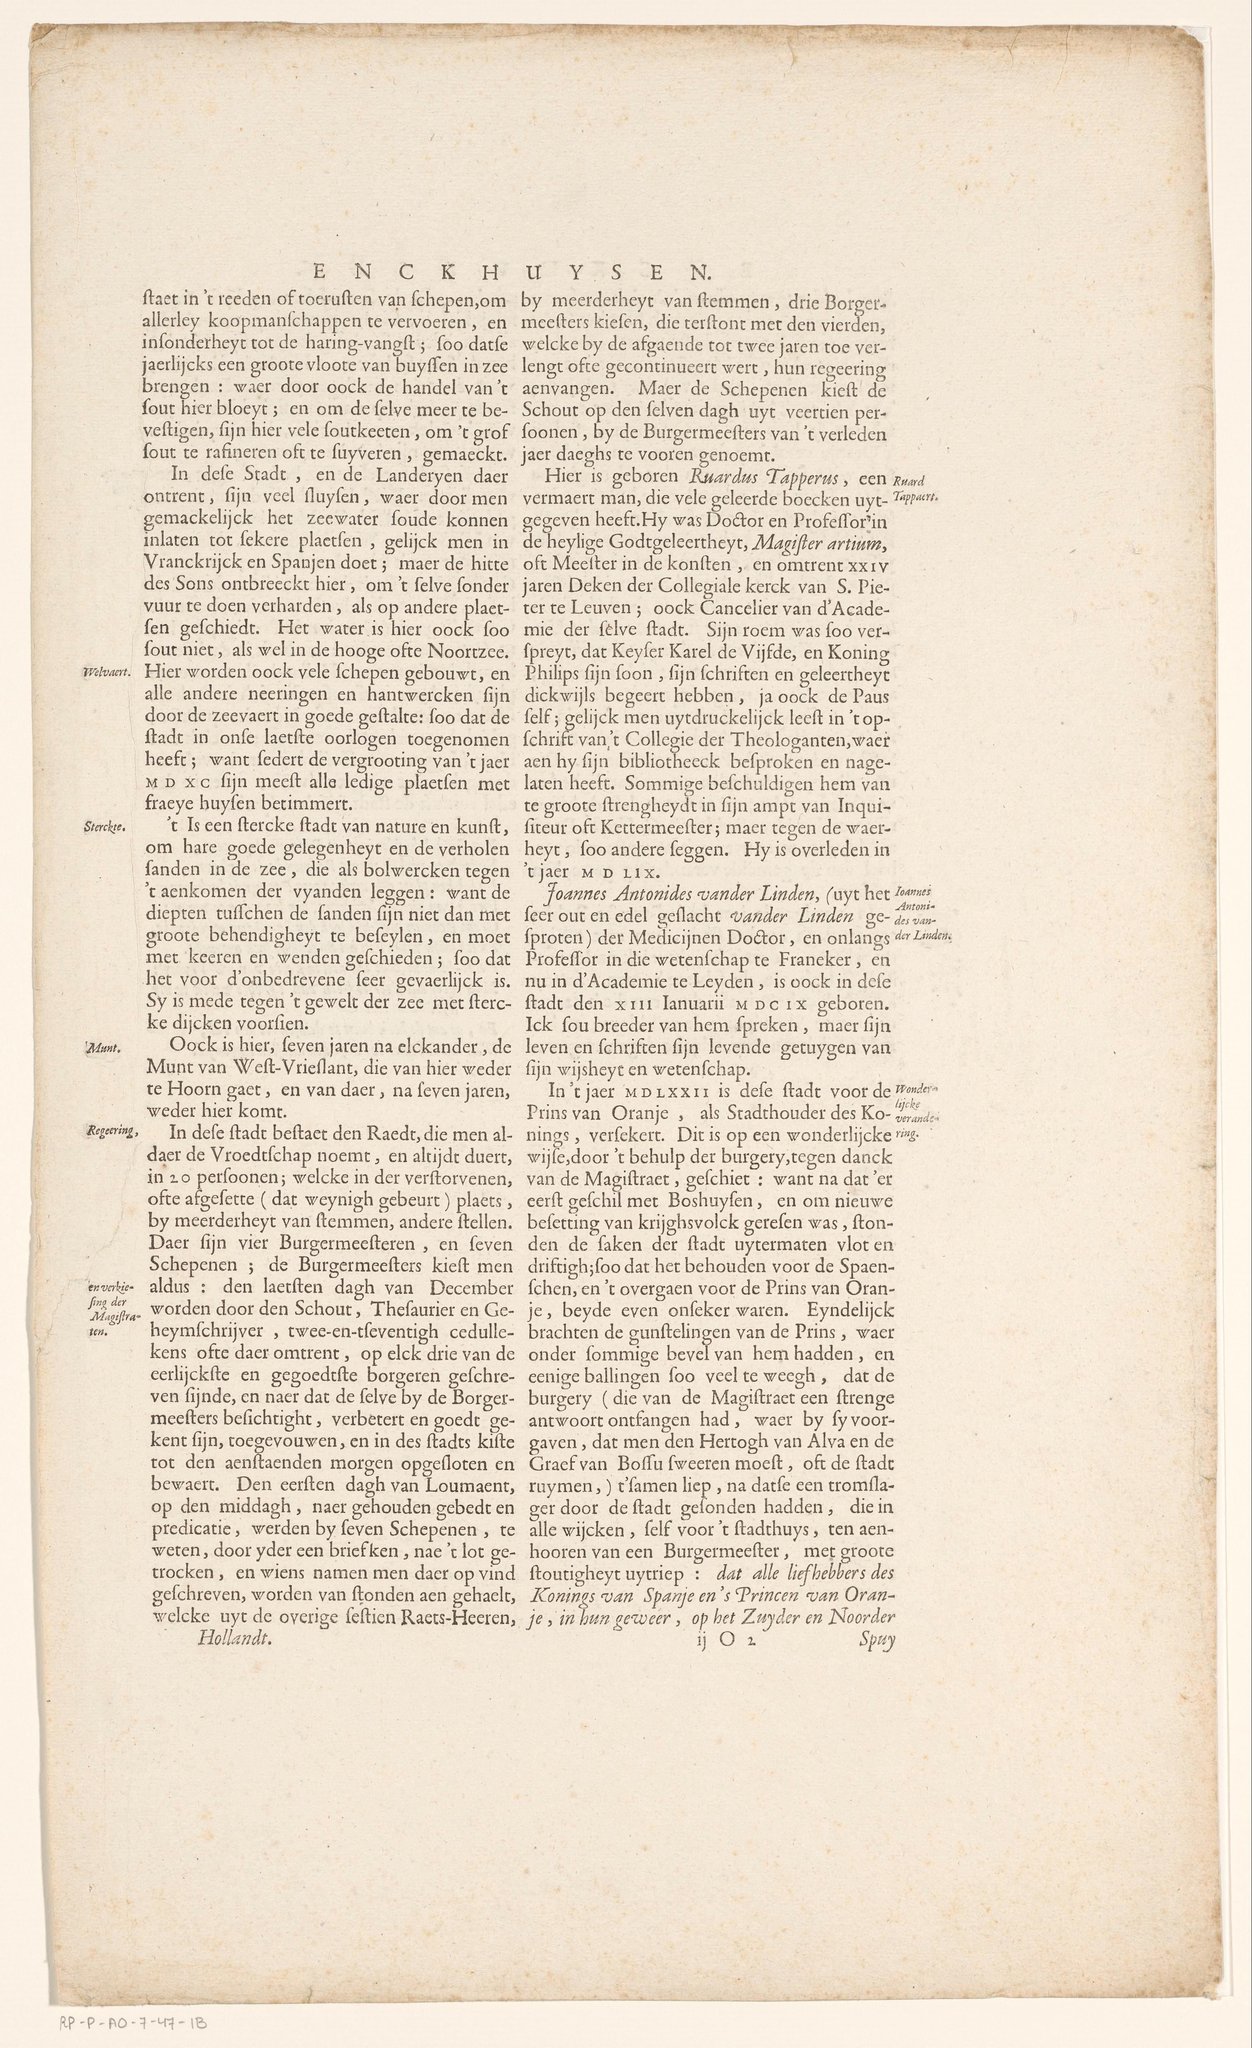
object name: text sheet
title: Enckhuysen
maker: johannes willemszoon blaeu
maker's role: printer, publisher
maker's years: 1596-1673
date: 1652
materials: paper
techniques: letterpress printing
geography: amsterdam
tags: enkhuizen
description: Deel van een beschrijving van de stad Enkhuizen uit Blaeu's 'Toonneel der steden van de Vereenighde Nederlanden'. Deze tekst is het vervolg van de tekst die op verso van RP-P-AO-7-47-1A staat.